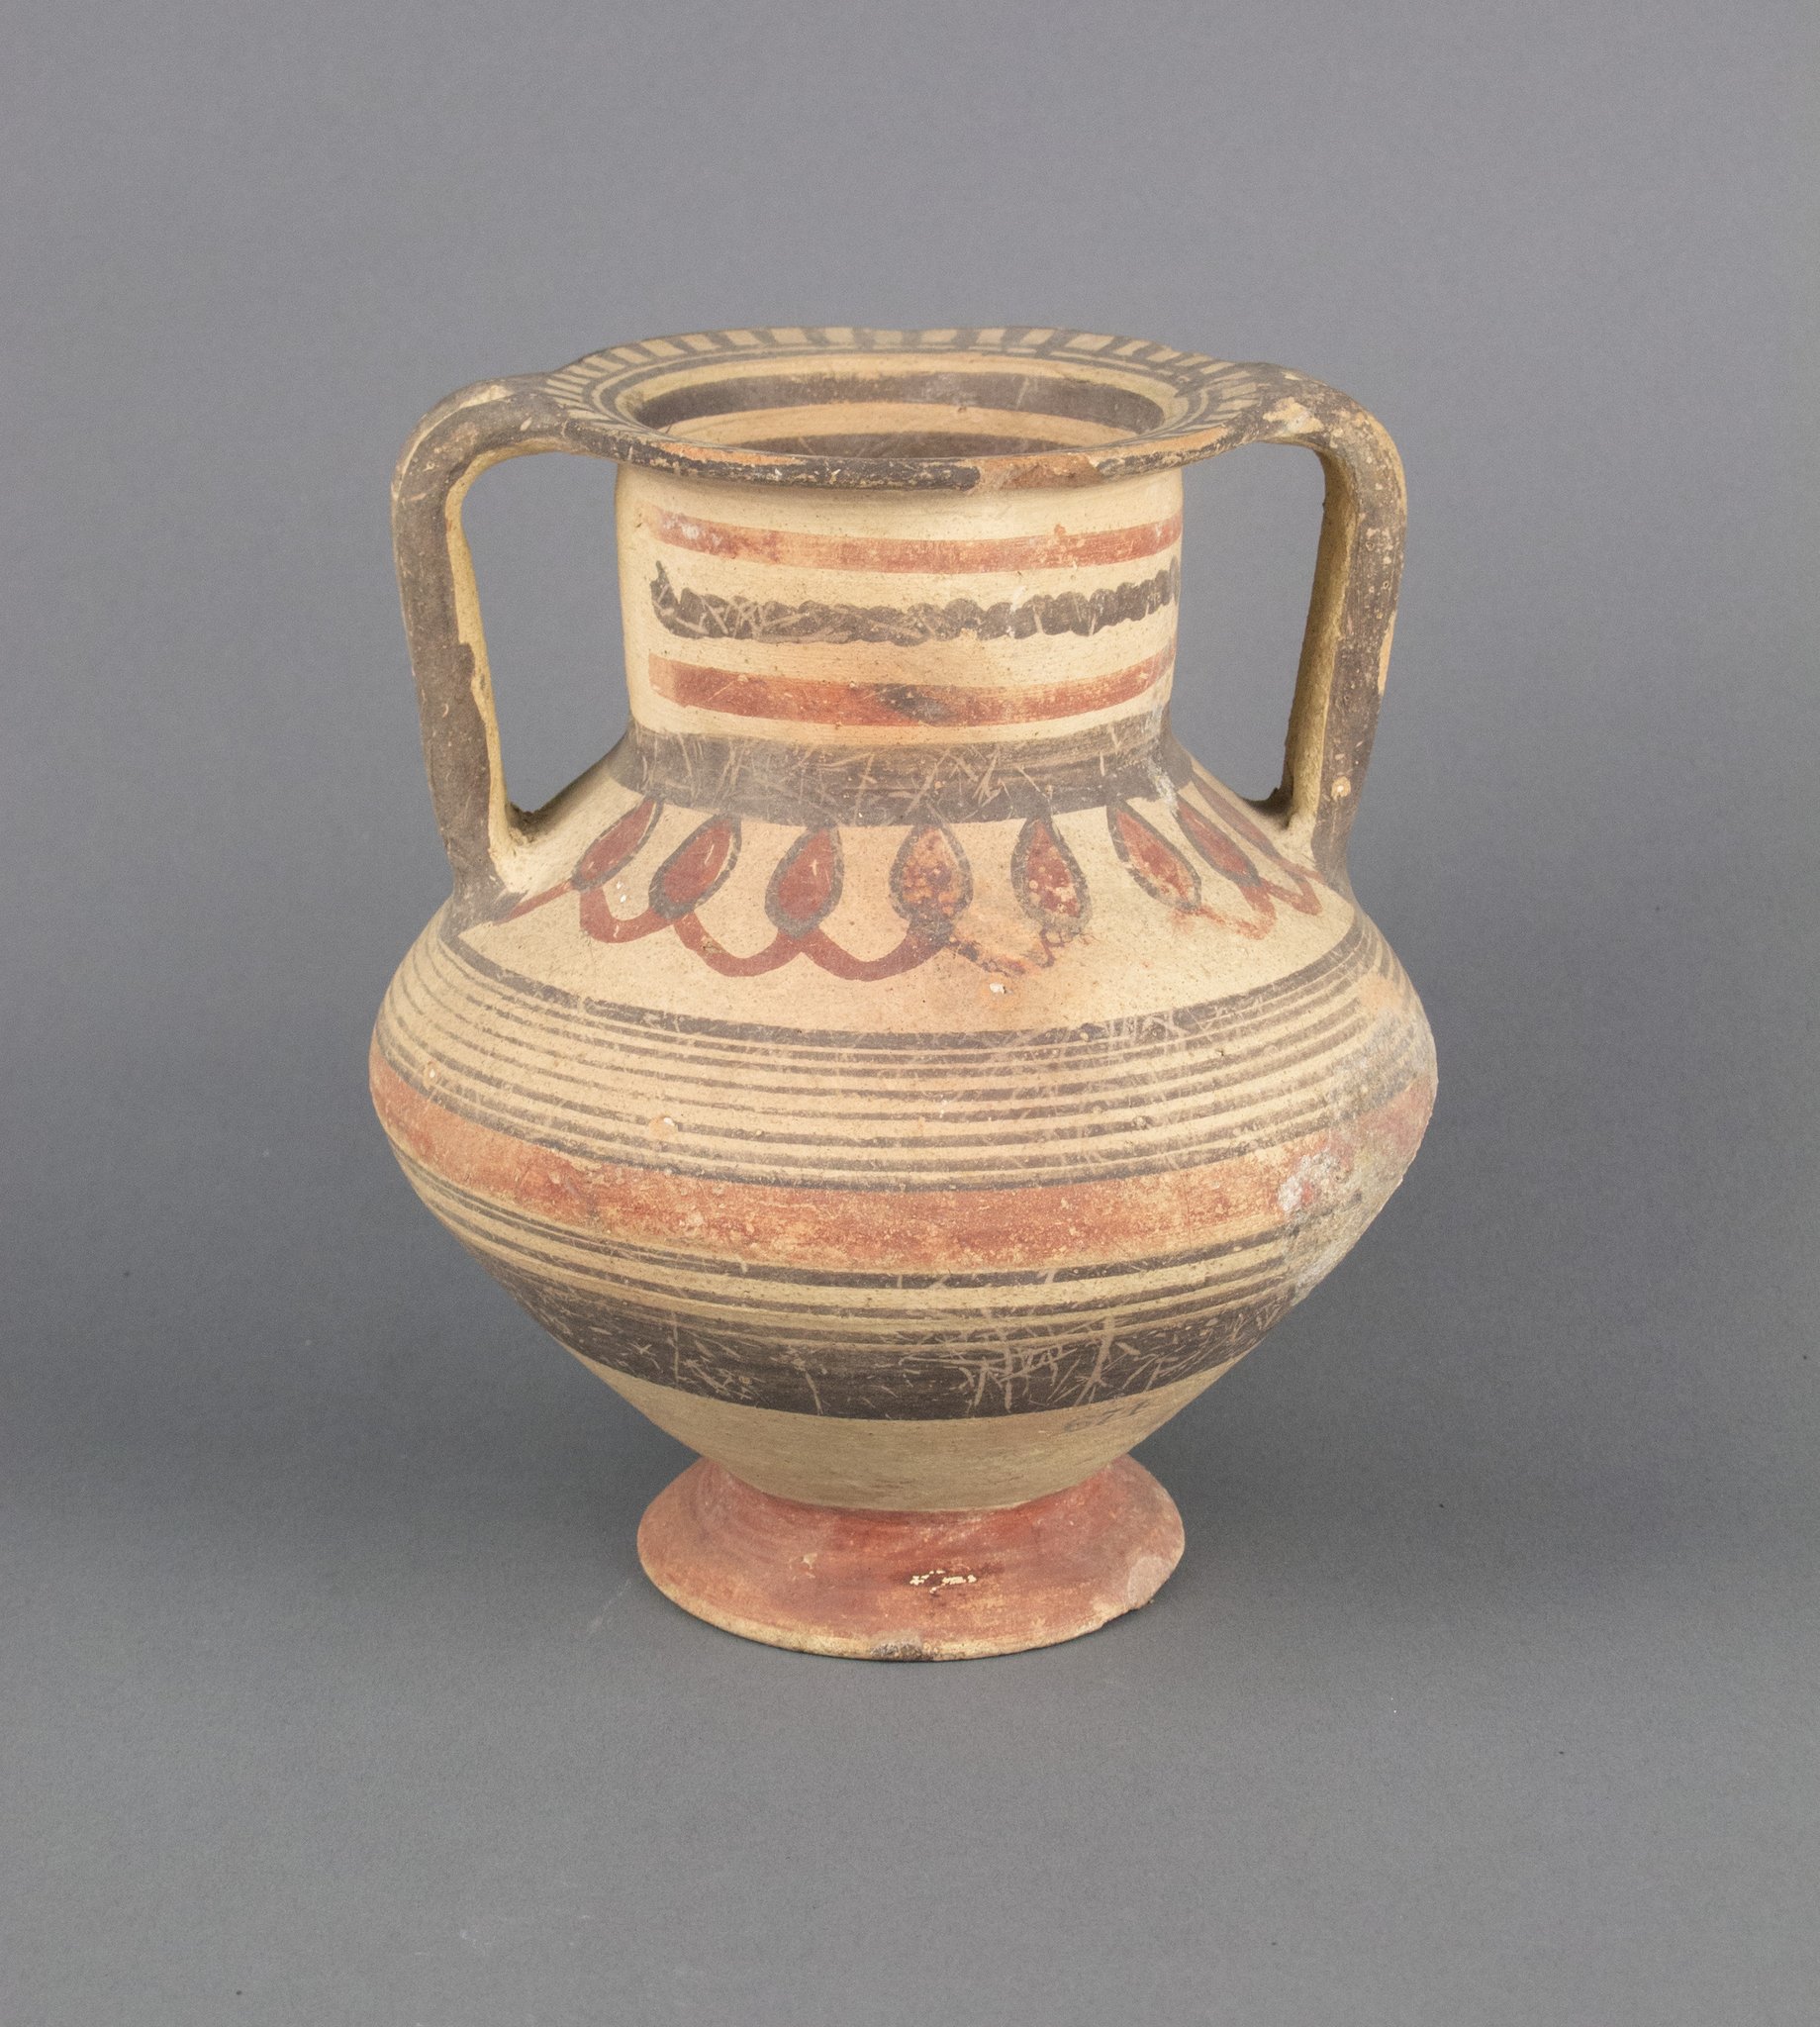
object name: amphora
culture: cypriot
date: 600-480 BCE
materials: terracotta